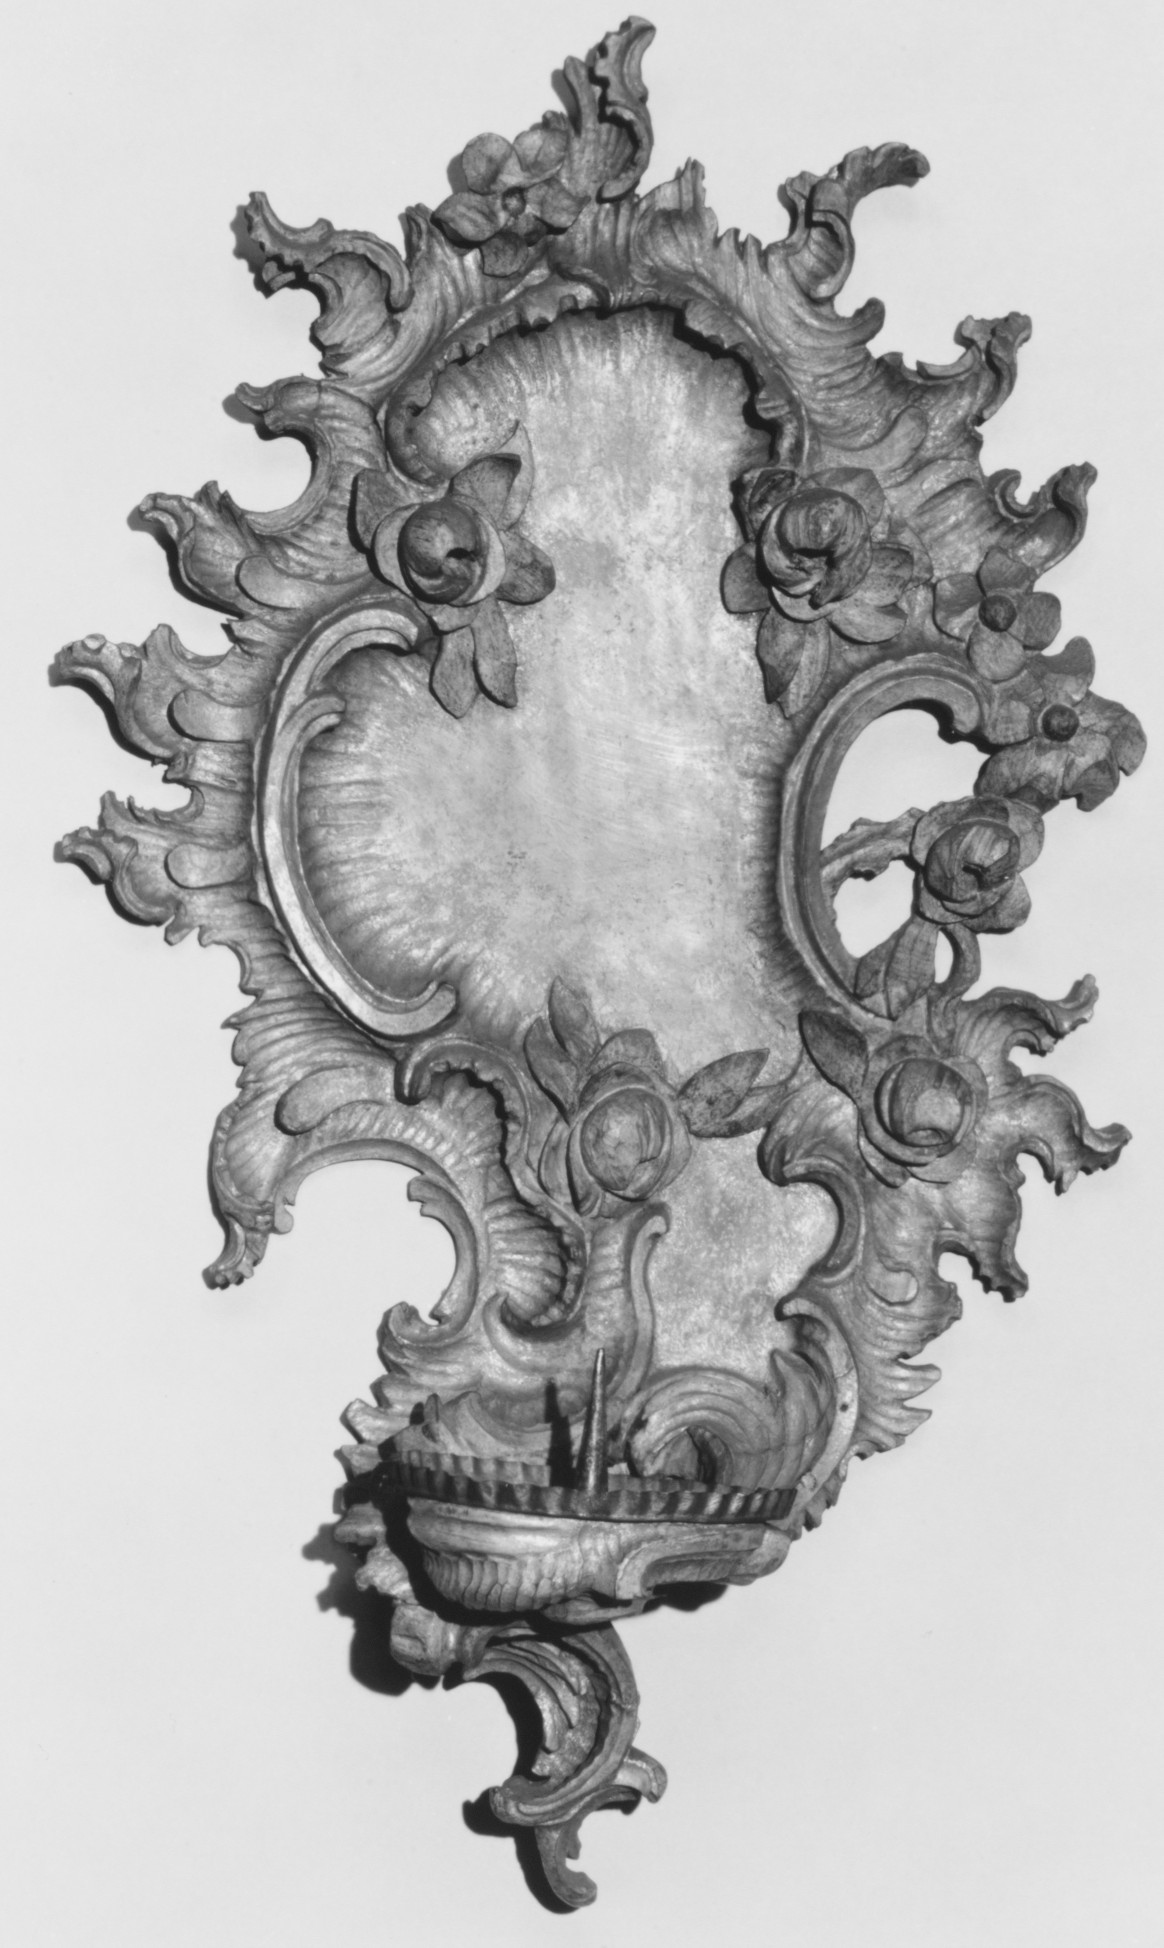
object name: wall bracket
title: Pair of single-light wall brackets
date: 1750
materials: wood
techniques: carving, gilding, painting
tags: flowers